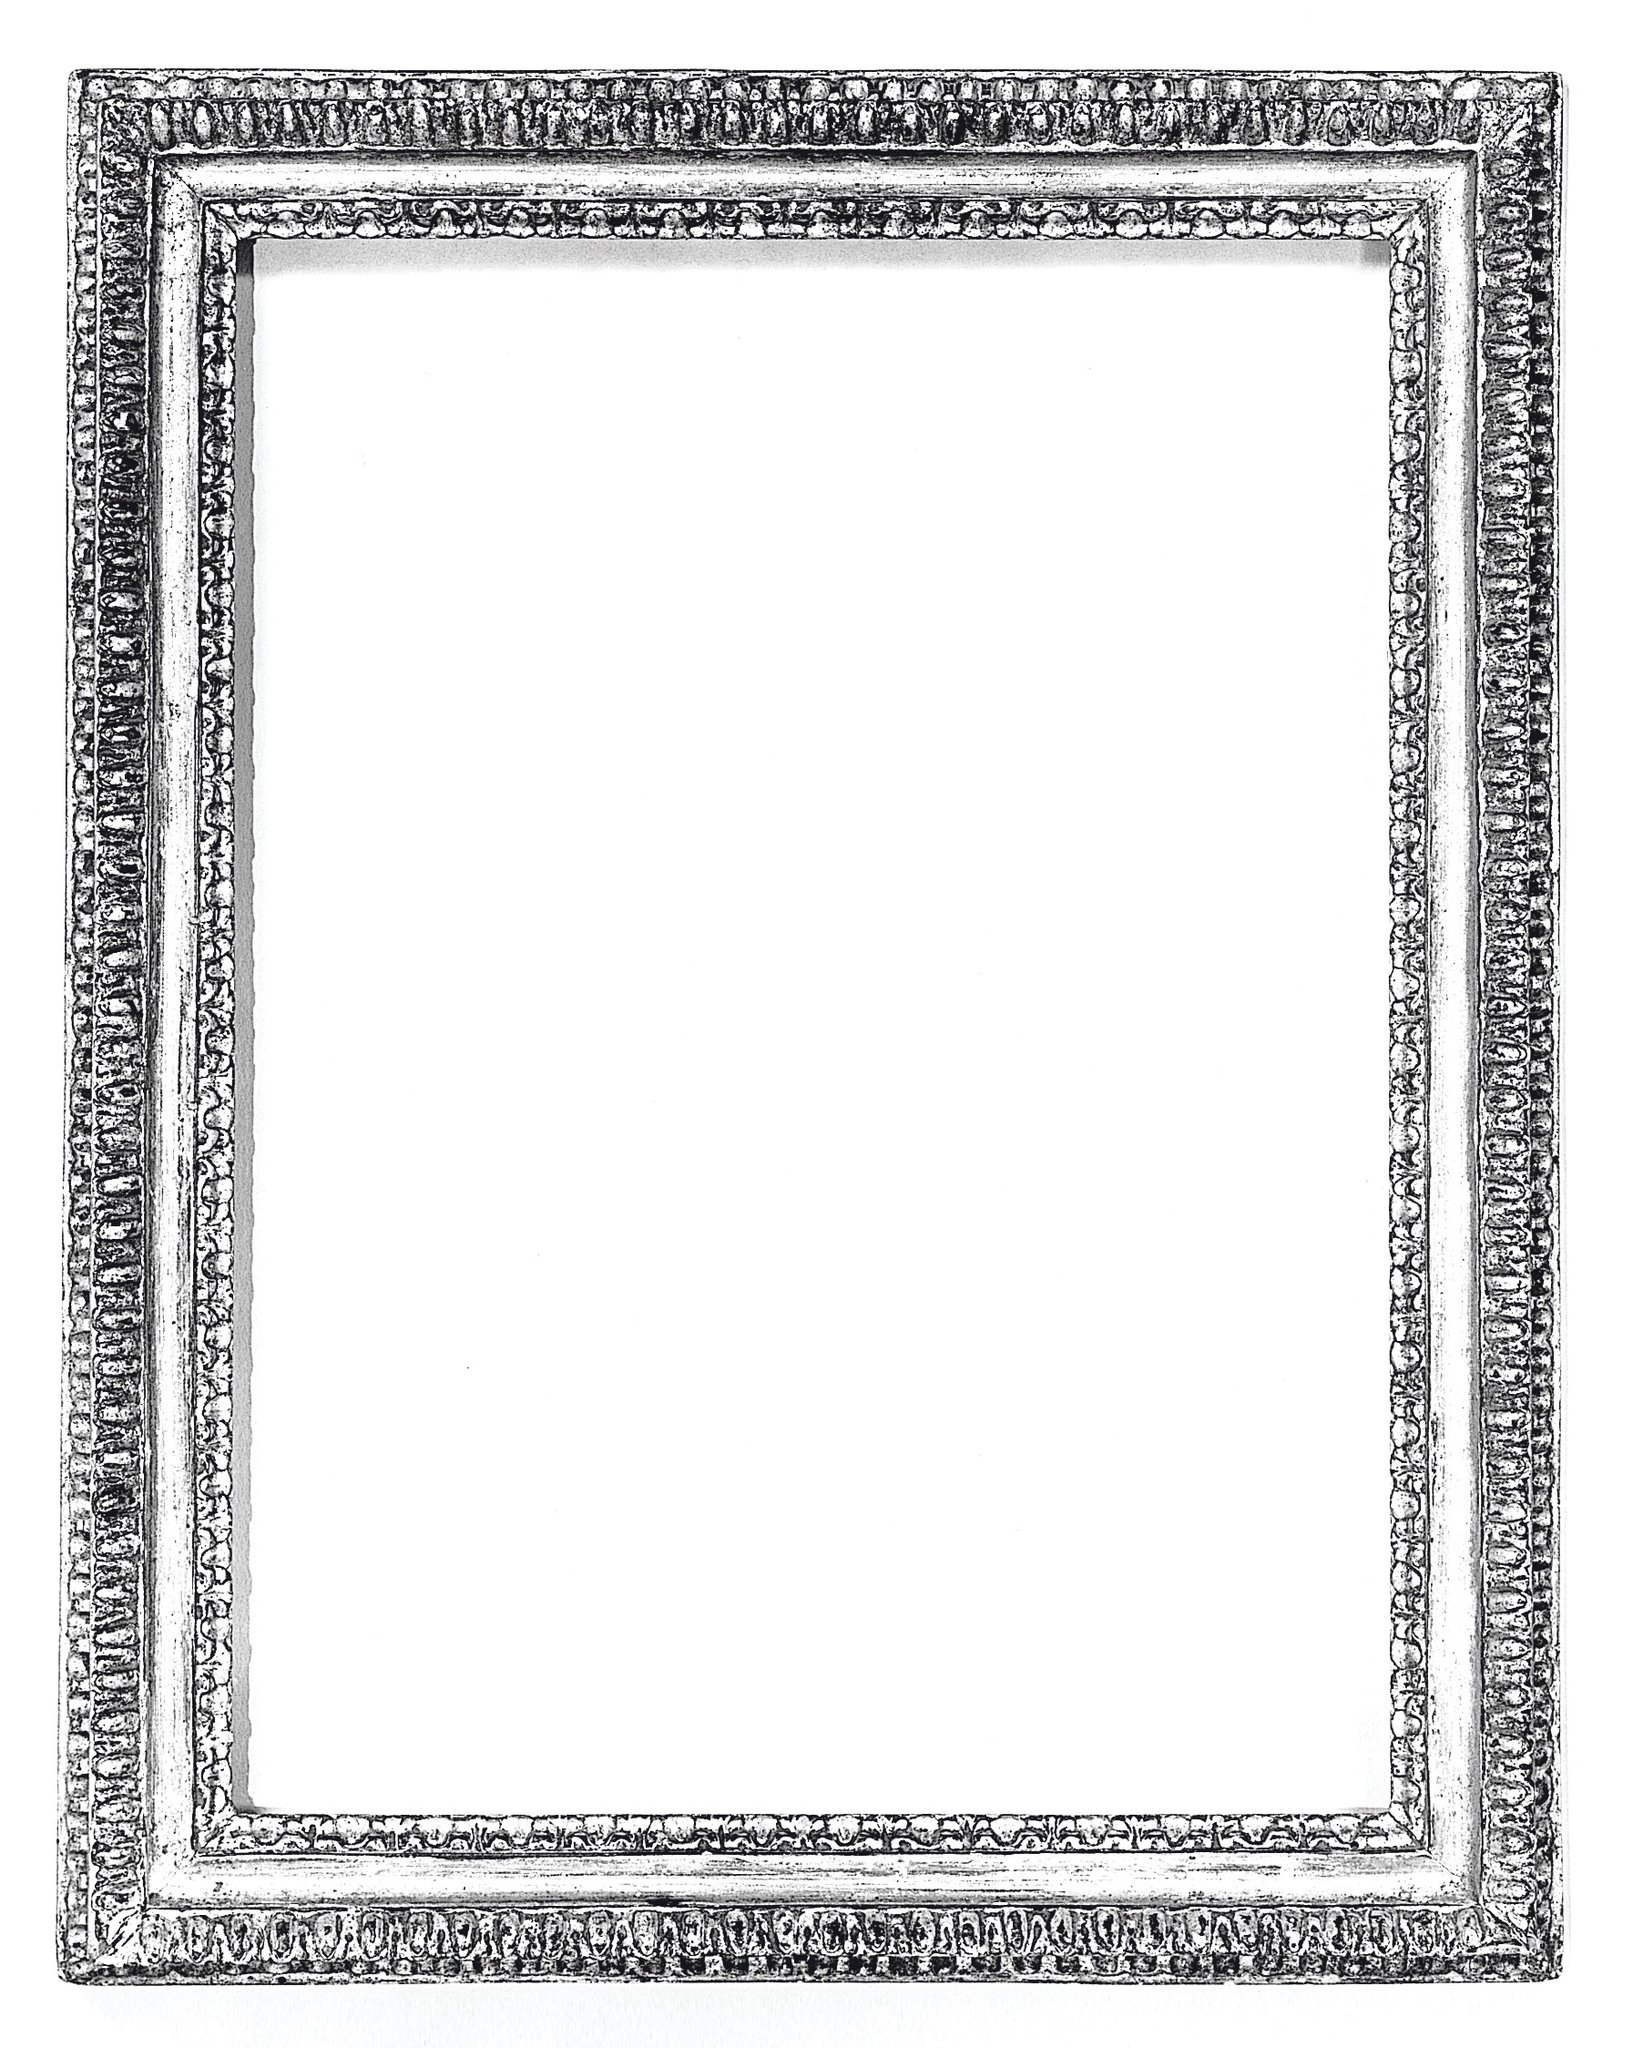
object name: frame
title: Salvator Rosa frame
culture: italian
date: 1770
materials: wood